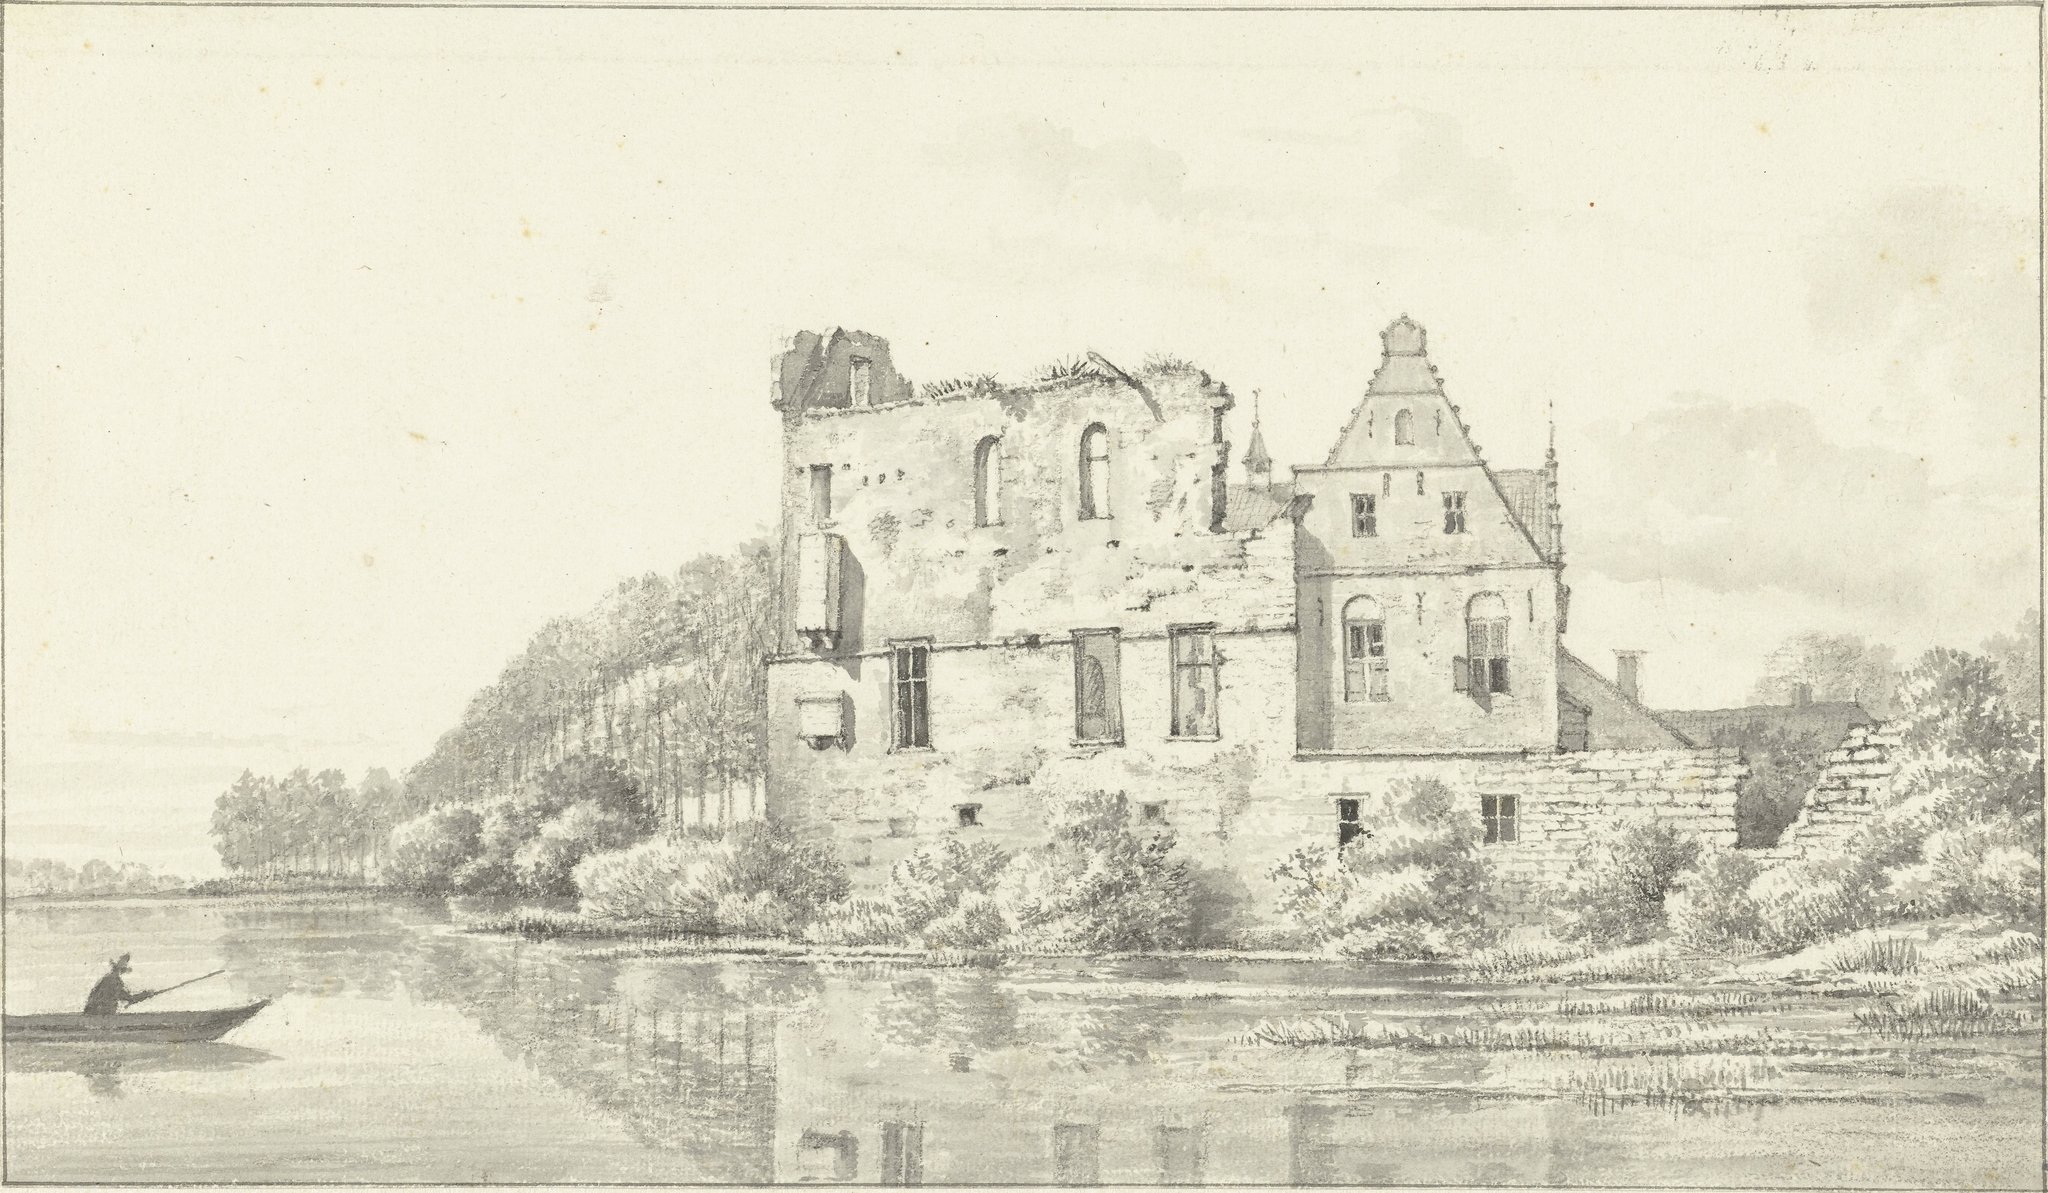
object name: drawing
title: Ruïne van Burg Altena te Schüttorf, graafschap Bentheim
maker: gerrit lamberts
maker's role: bookseller, draughtsman, print maker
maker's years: 1776-1850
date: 1786-1850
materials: chalk, paper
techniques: brush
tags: castle, ruin of a building ~ architecture, germany